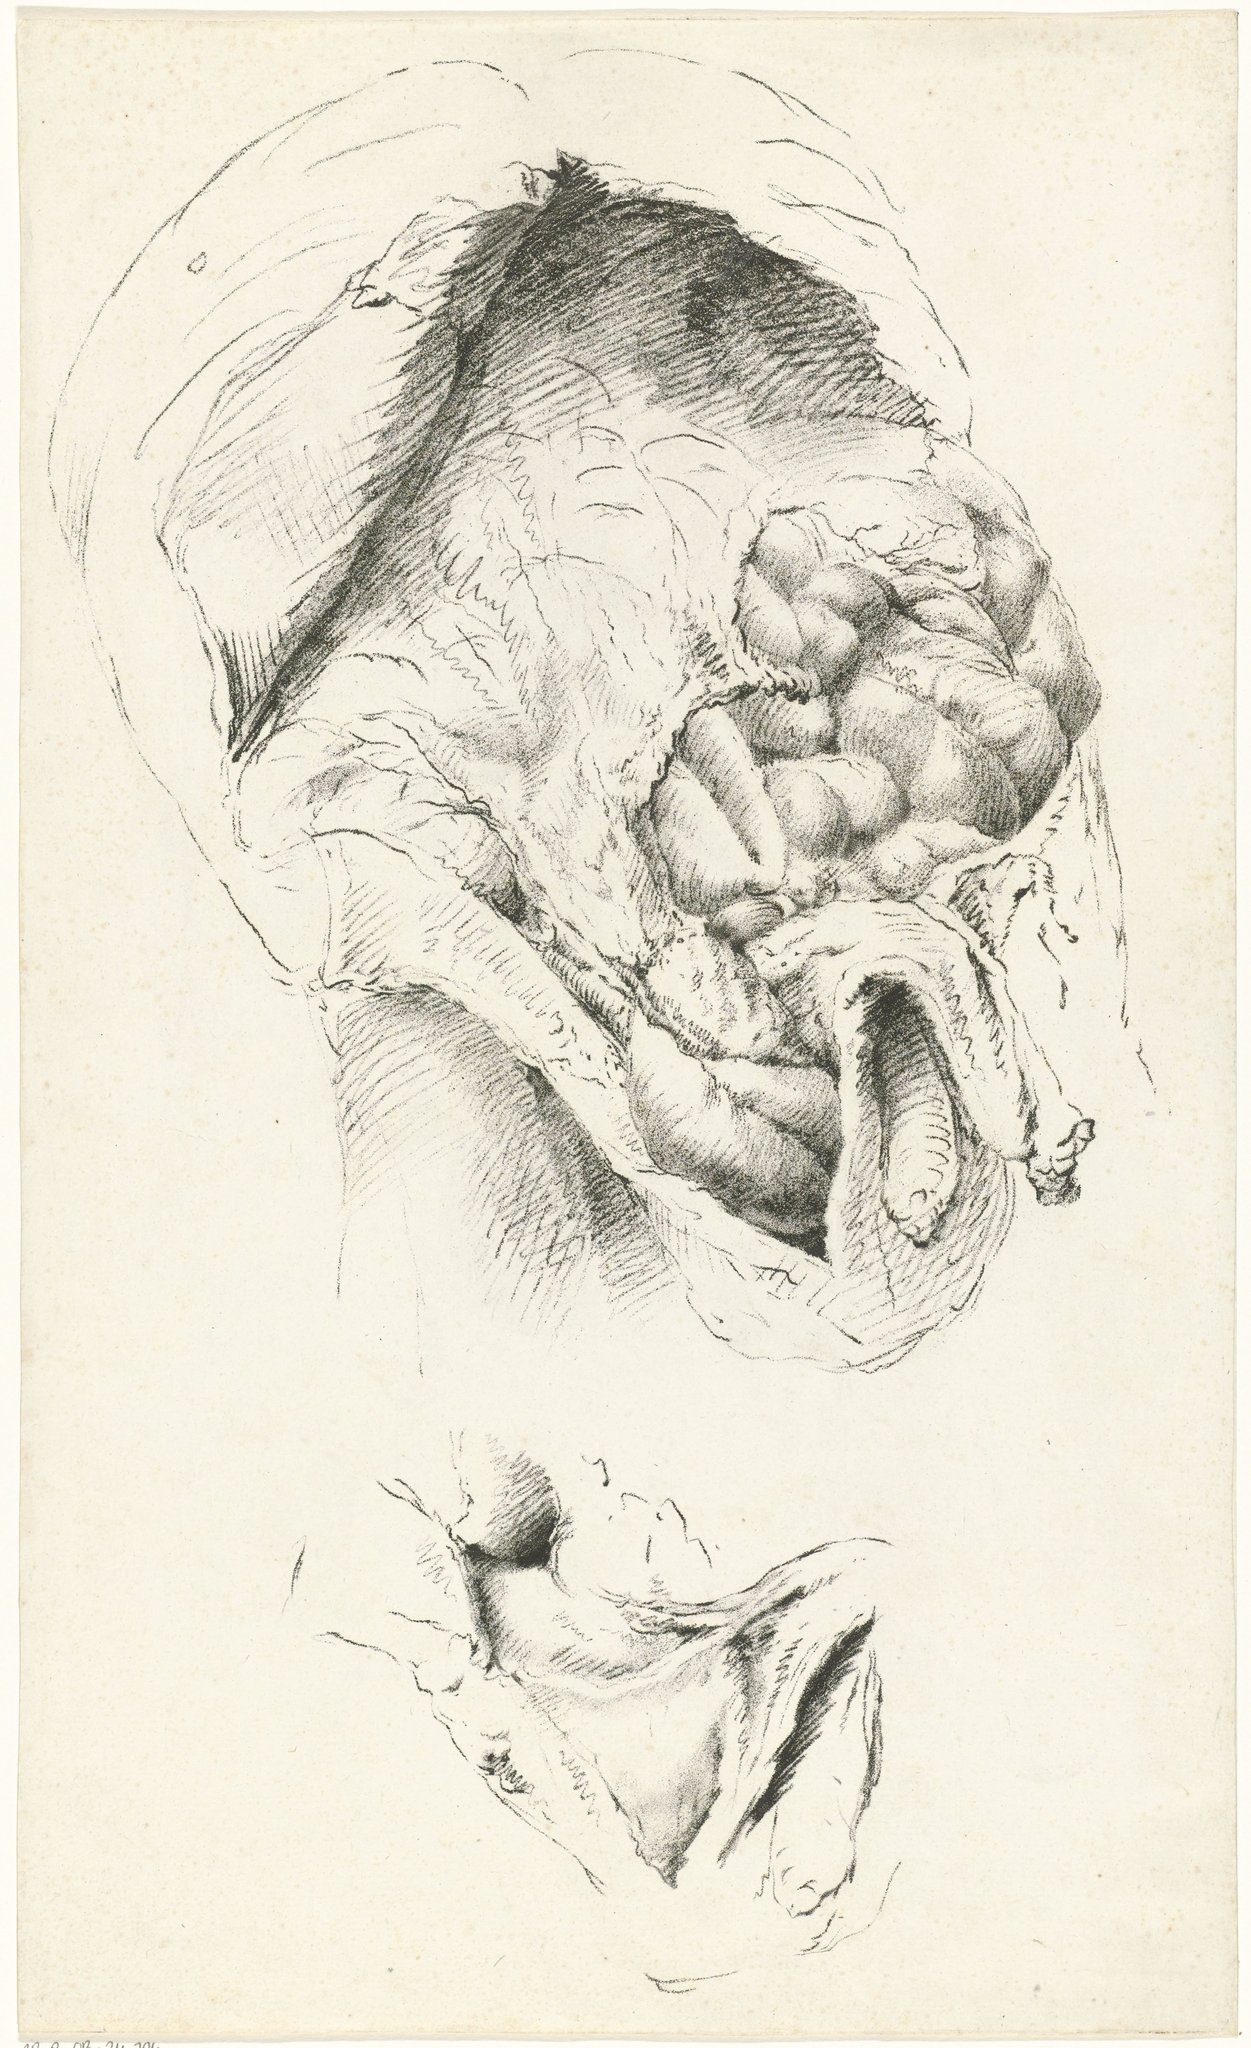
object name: print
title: Ontleed kinderlichaam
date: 1758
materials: paper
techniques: etching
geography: amsterdam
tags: abdomen, belly (human being), physiology and anatomy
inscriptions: collector's mark: Lugt 240, inscription: ‘de Buick van een Kindje, ontleed naar de dood - door Doctor Jb Ploos van Amstel / geoffreerd aan mijne neef! den WEd Heer J L v Dussen 1772 / George van der Myn del 1758 Ploos v Amstel JC F: 1758’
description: Anatomiestudie van de buik van een kind.